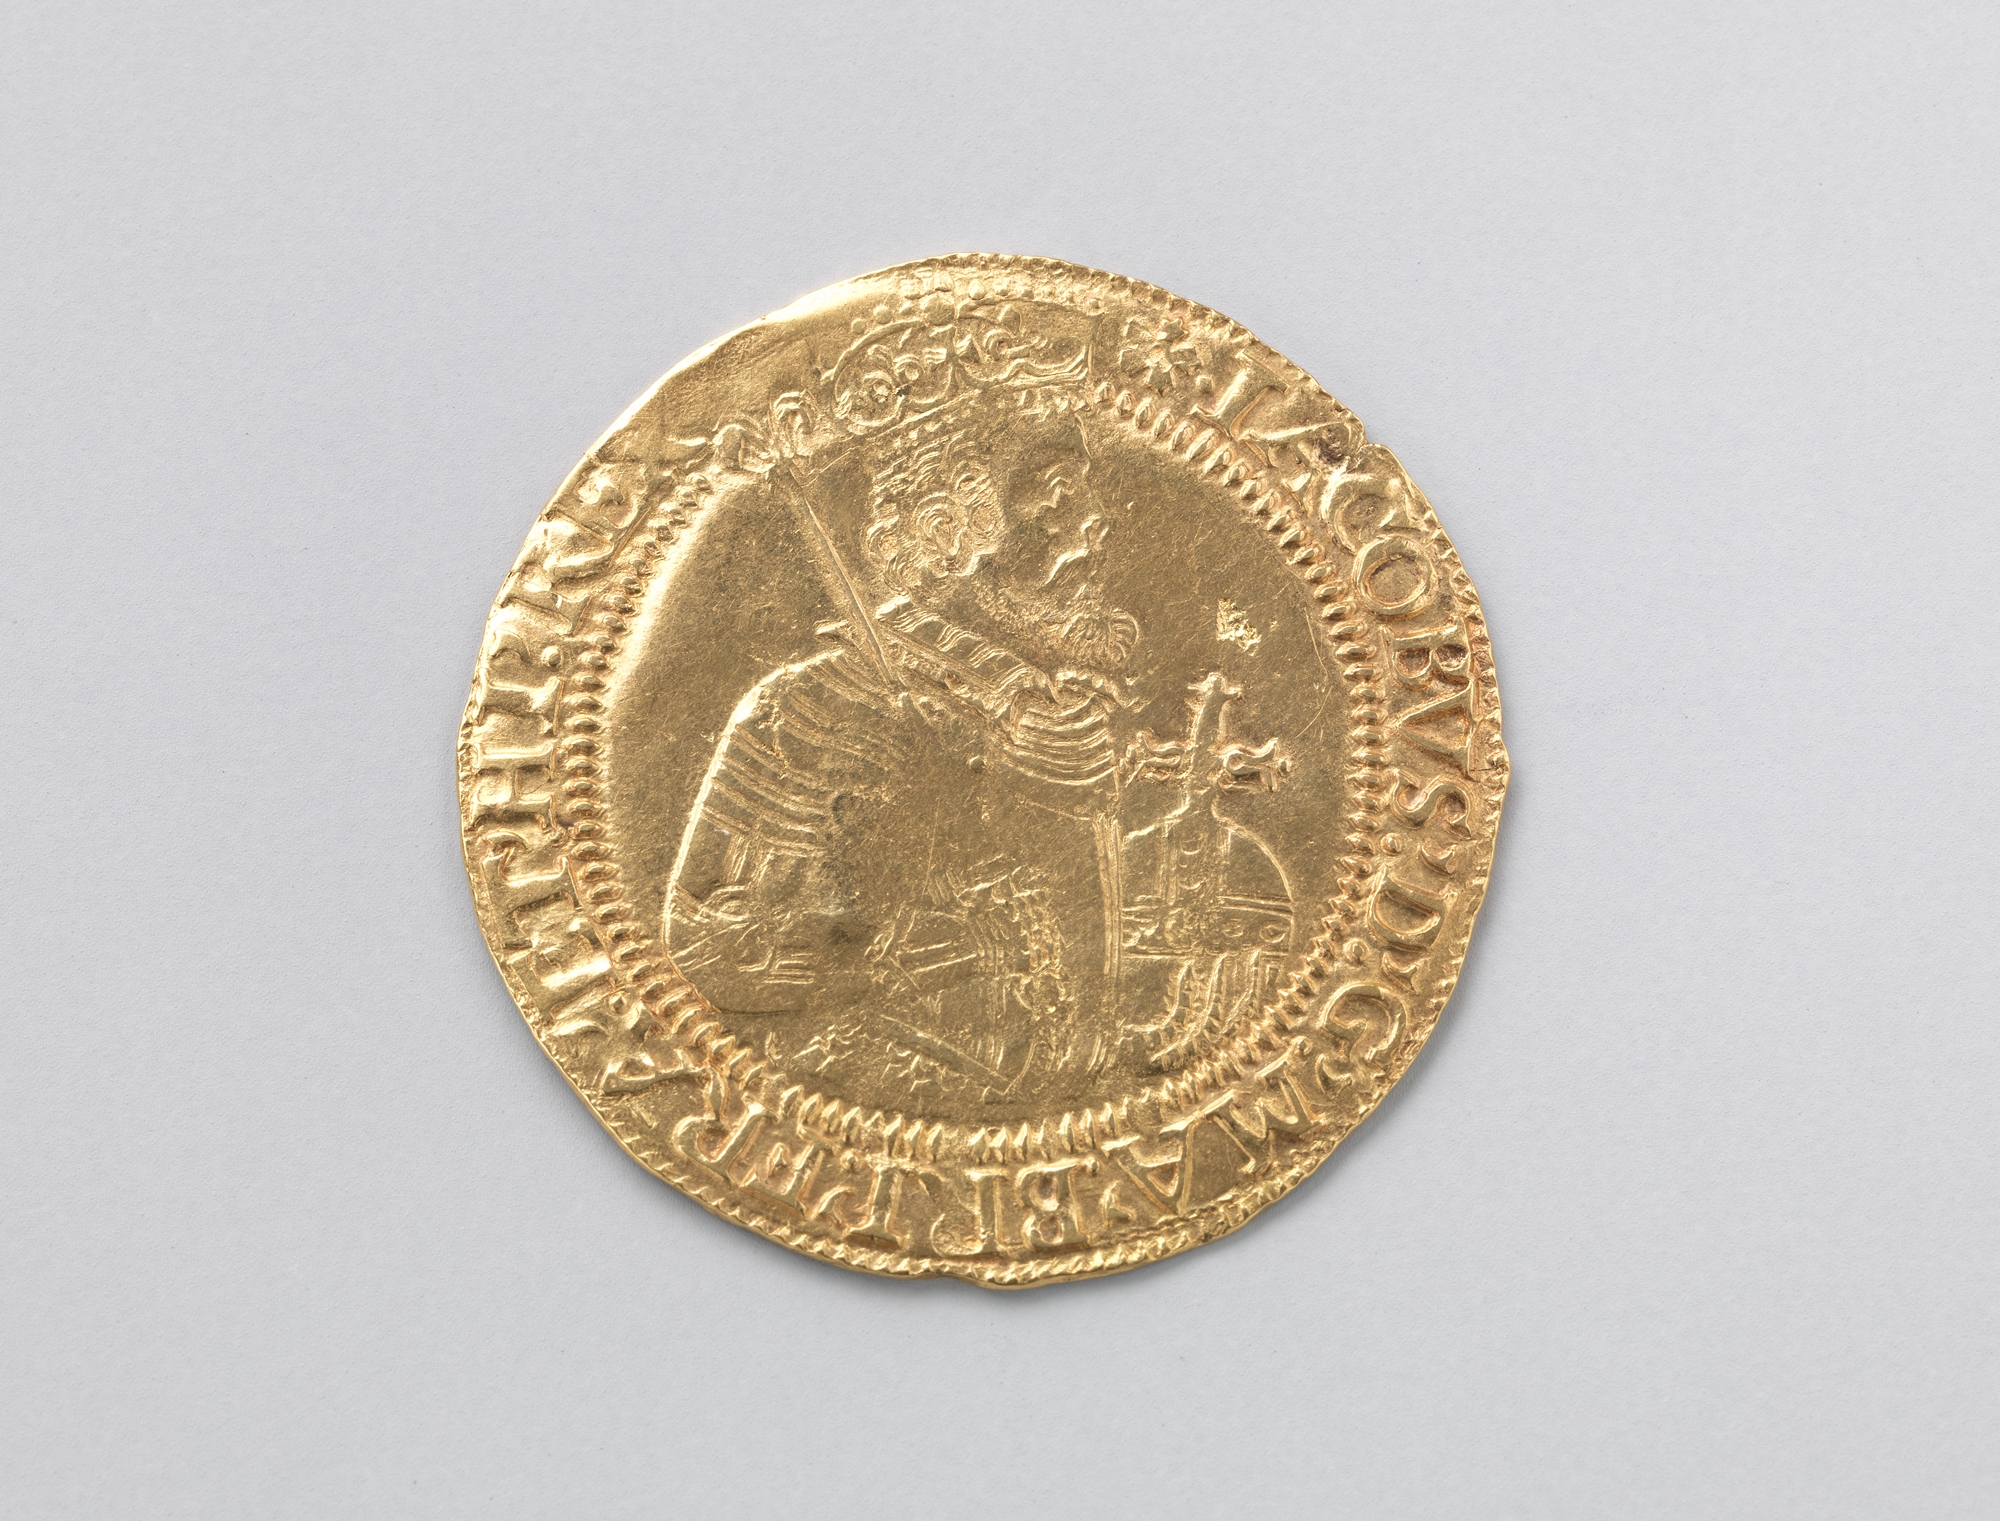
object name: unite coin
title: Unite coin of James I (r. 1603–25)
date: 1613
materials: gold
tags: men,profiles,coins